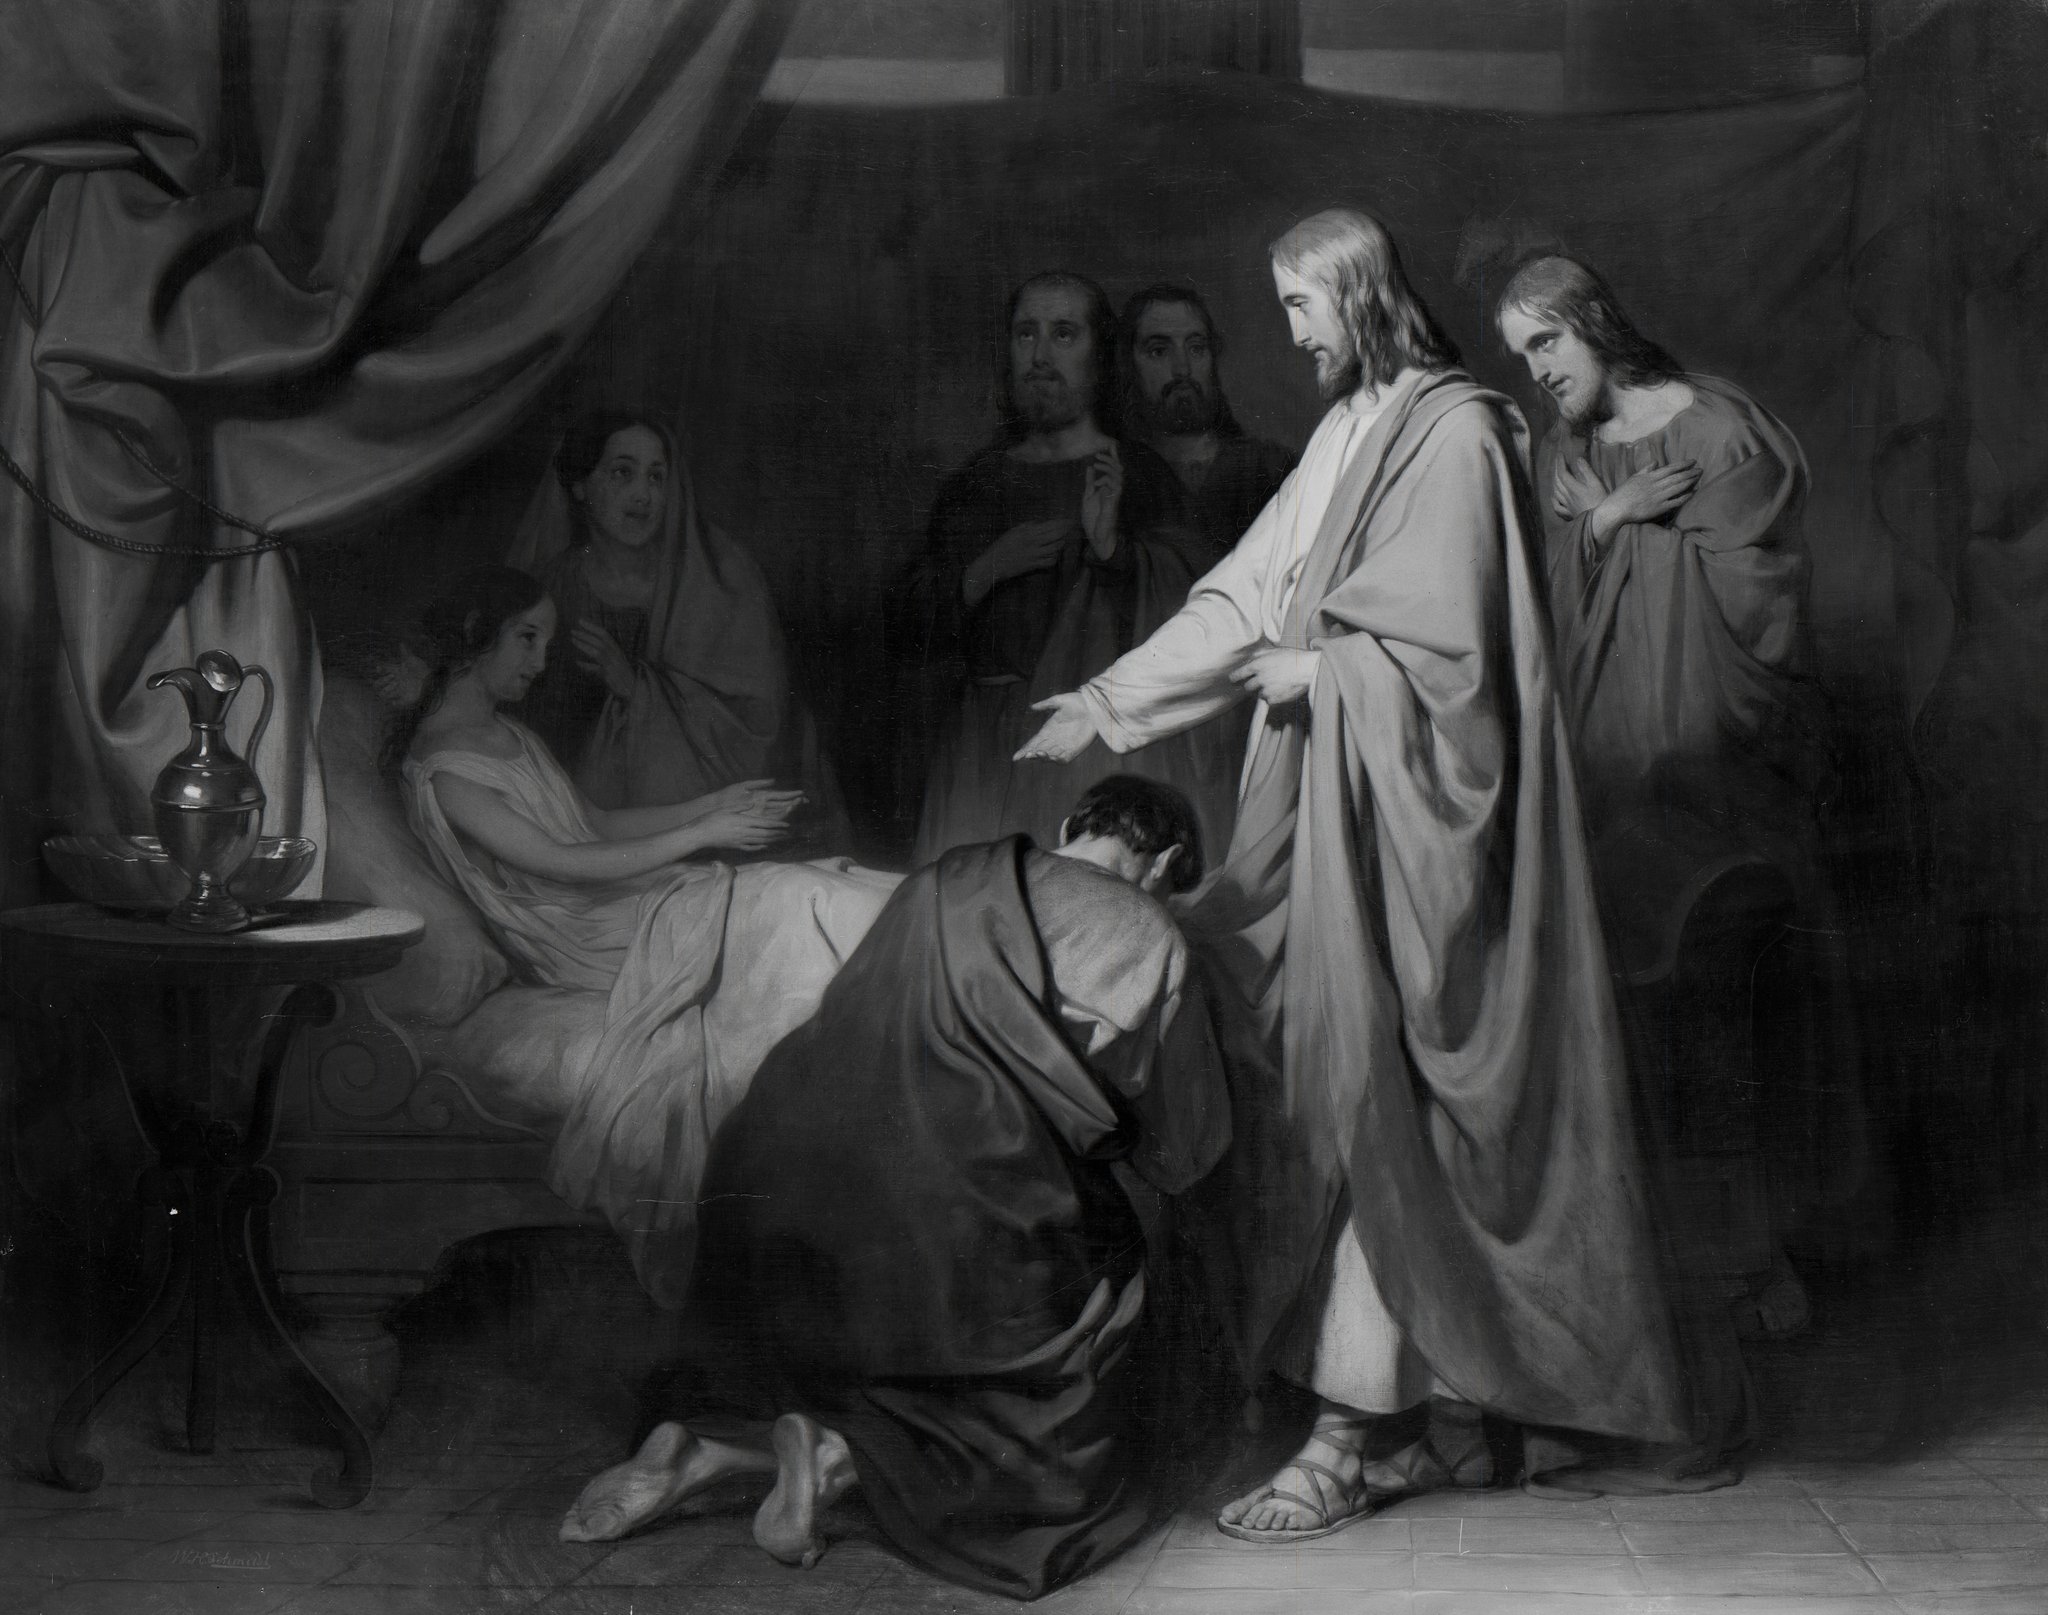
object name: painting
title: De opwekking van het dochtertje van Jaïrus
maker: willem hendrik schmidt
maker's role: draughtsman, painter, print maker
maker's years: 1809-1849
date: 1830-1849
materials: canvas, oil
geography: netherlands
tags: raising of the daughter of jairus, who is lying in bed (matthew 9:18-19, 9:23-26; mark 5:21-24, 5:35-43; luke 8:40-42, 8:49-56)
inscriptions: signature: ‘W.H. Schmidt’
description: De opwekking van de dochter van Jaïrus. Rechts staat Christus tussen enkele van zijn discipelen met uitgestoken hand naar het tot leven gewekte meisje, Jaïrus knielt aan zijn voeten, de moeder staat naast het bed.